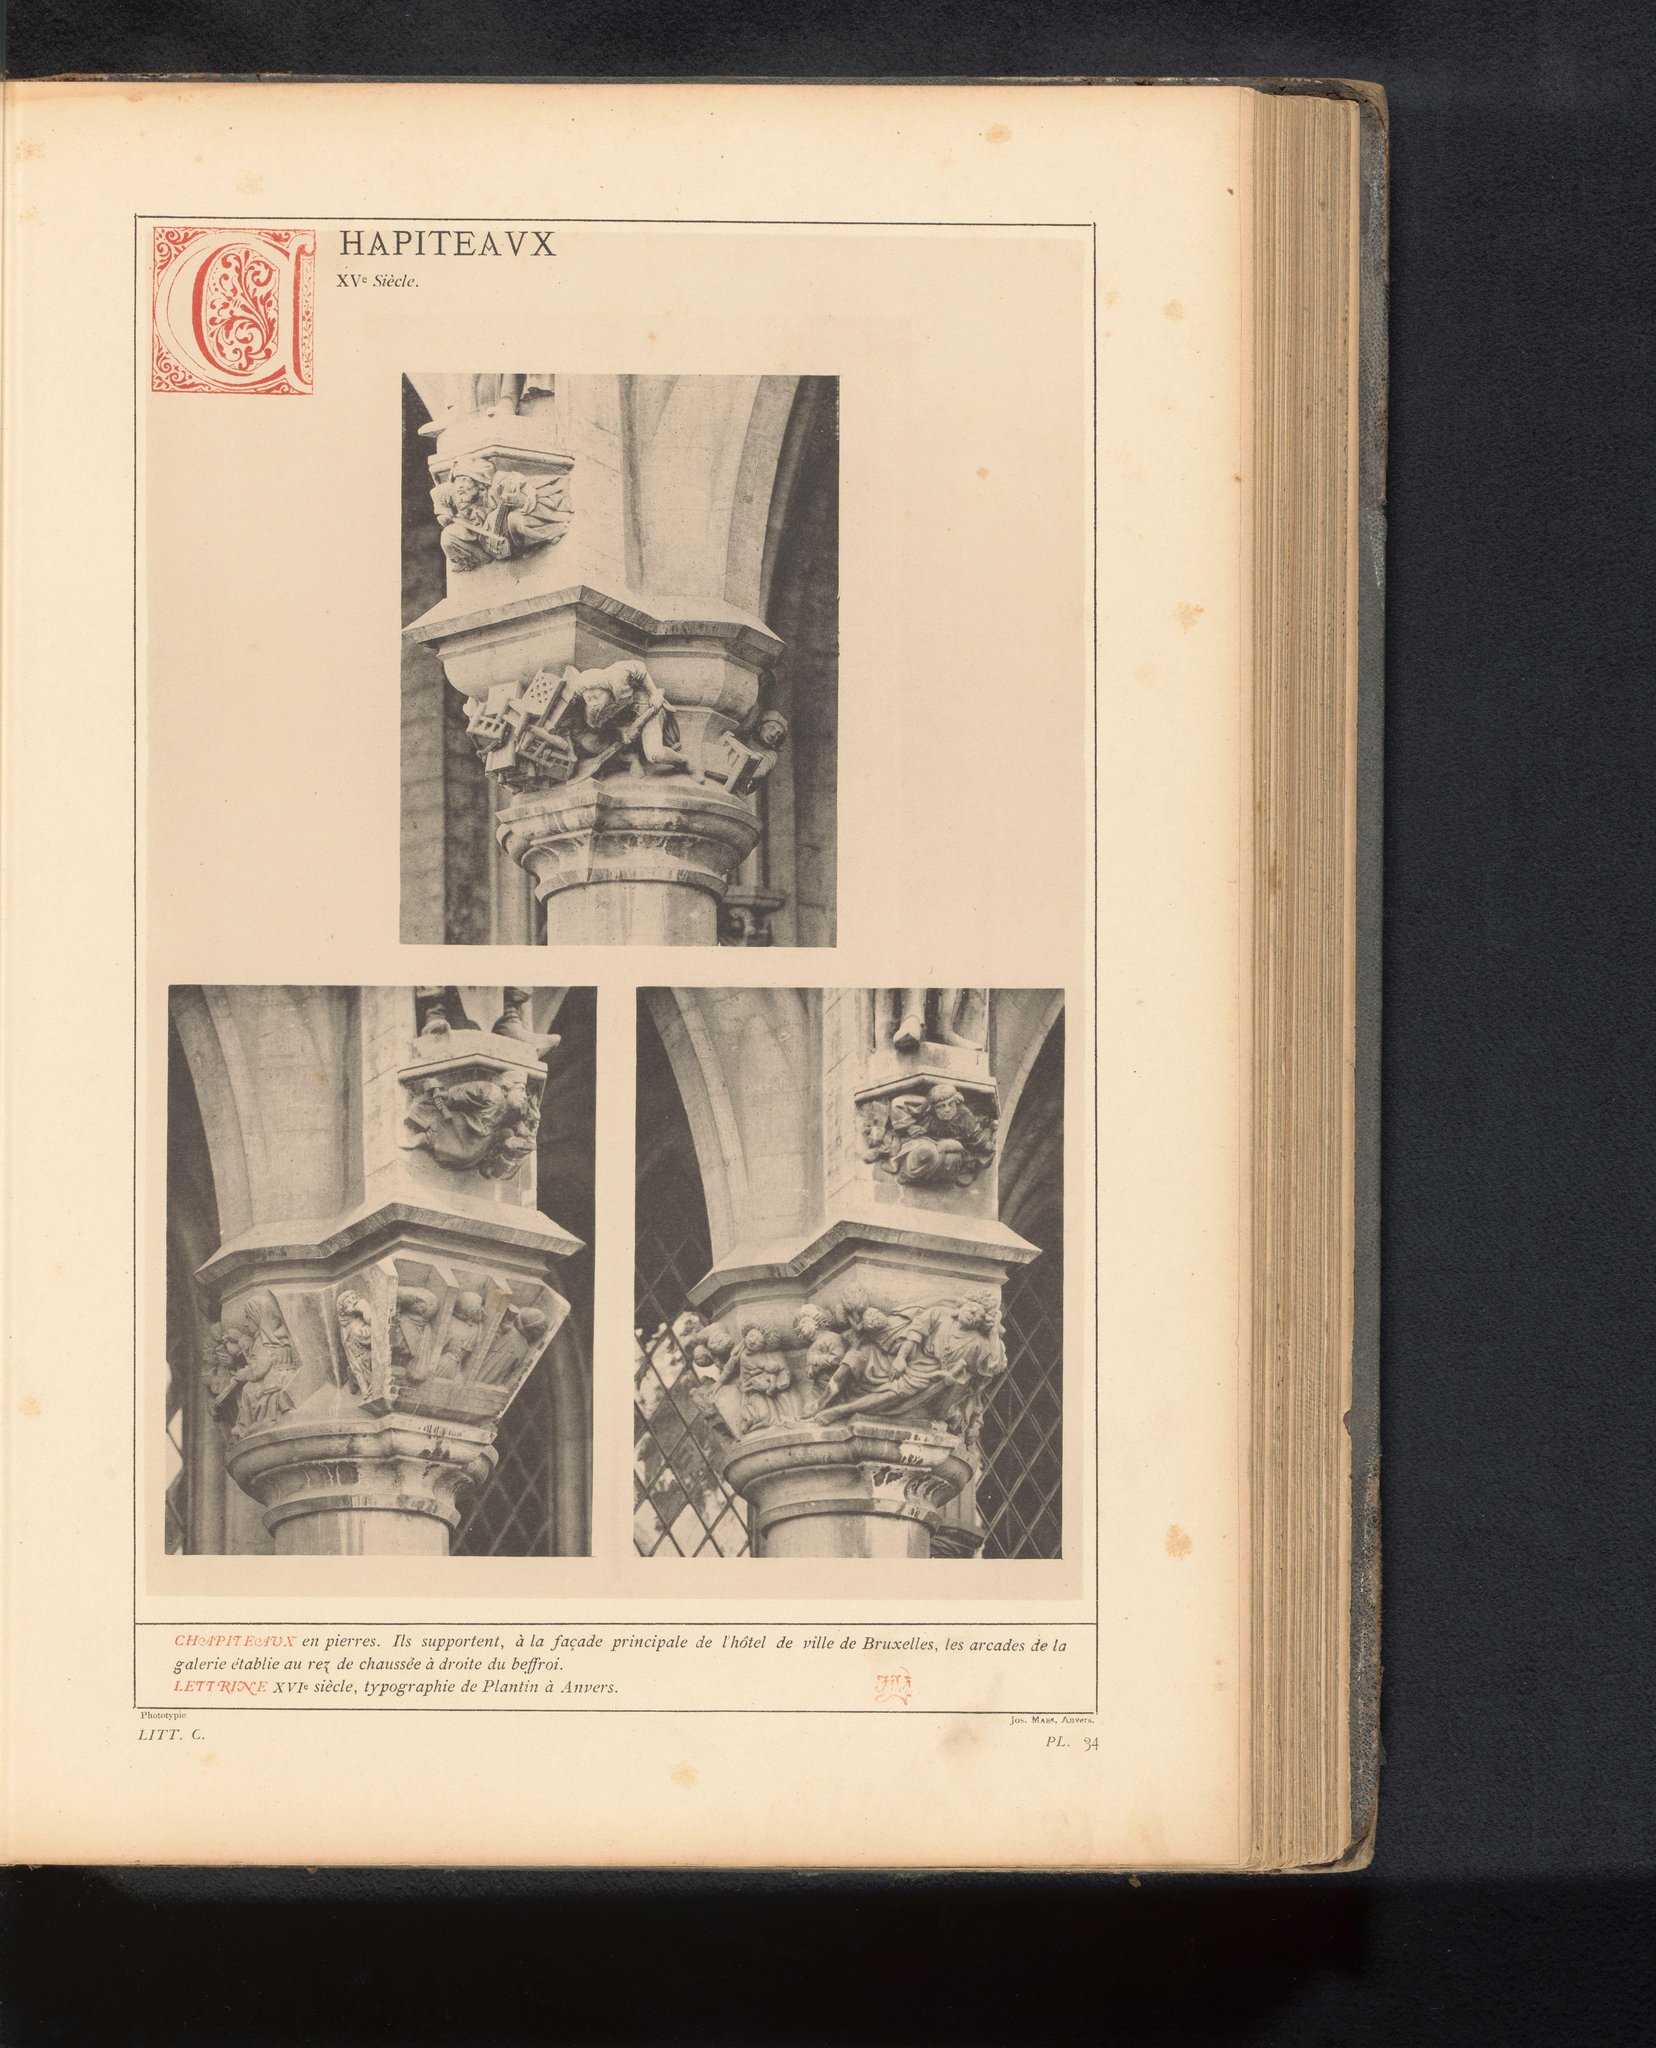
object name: page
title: Drie opnames van kapitelen van het stadhuis van Brussel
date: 1875-1880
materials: paper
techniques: photograph, photolithography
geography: brussels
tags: capital (~ column, pillar)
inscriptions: monogram: ‘JJvY’, inscription: ‘Chapiteaux en pierres (...)’, inscription: ‘LITT. C. - PL. 34’